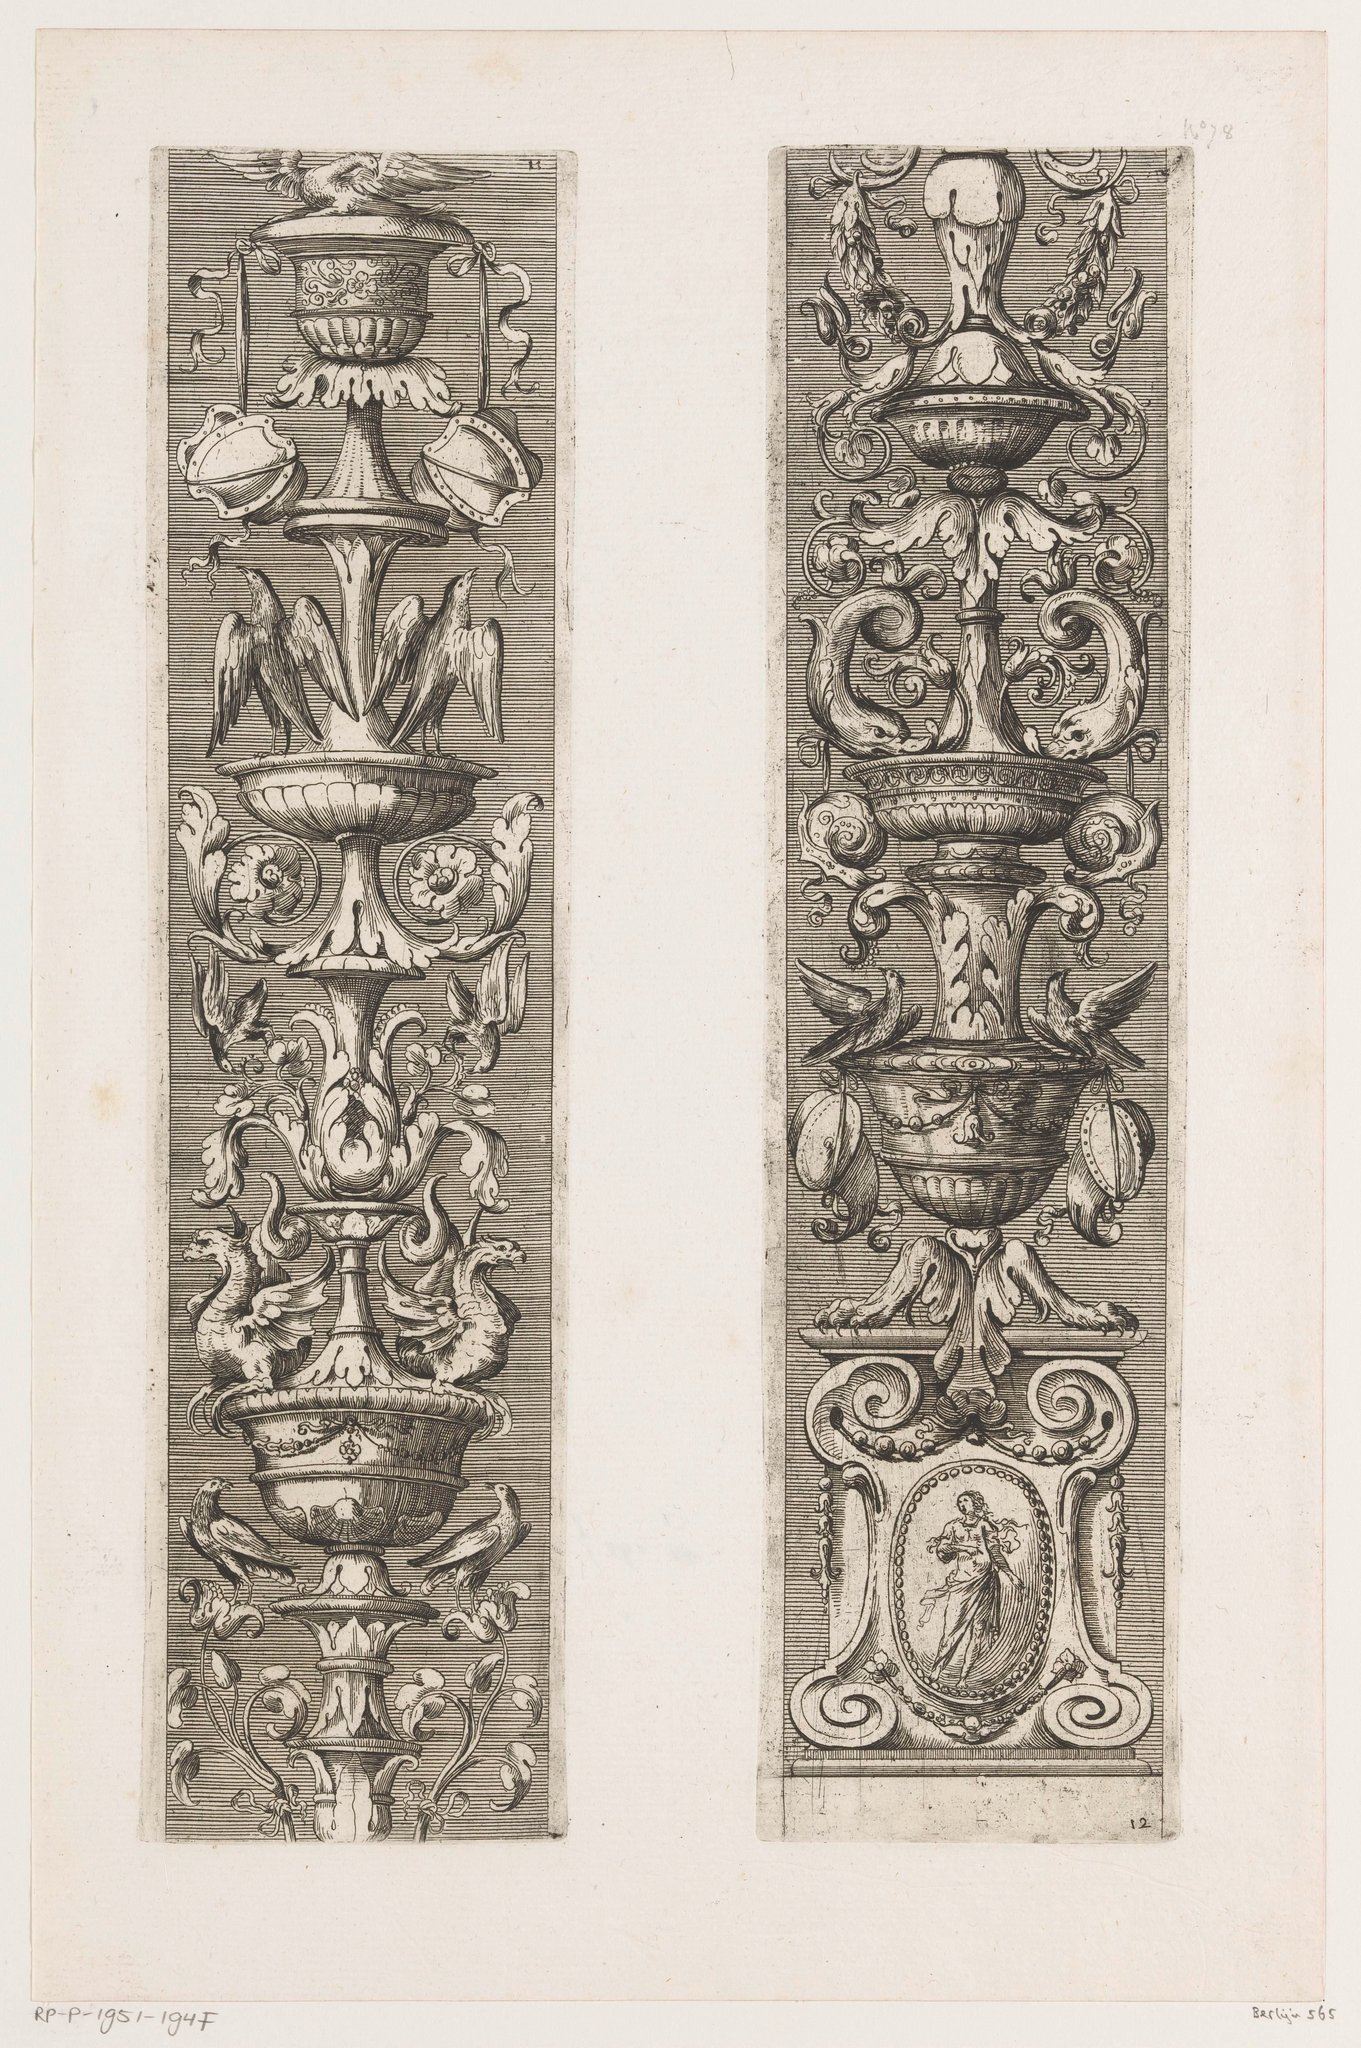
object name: print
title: Kandelabers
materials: paper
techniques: etching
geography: rome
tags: ornament ~ candelabrum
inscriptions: collector's mark: Lugt 2228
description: Deze prent maakt deel uit van een reeks van 48 prenten plus een titelprent. Mitelli maakte tekeningen van marmeren pilasterdecoraties van de poort van de S. Bartolomeo di Porta Ravegnana in Bologna. Deze prenten zijn vervolgens naar die tekeningen gemaakt.